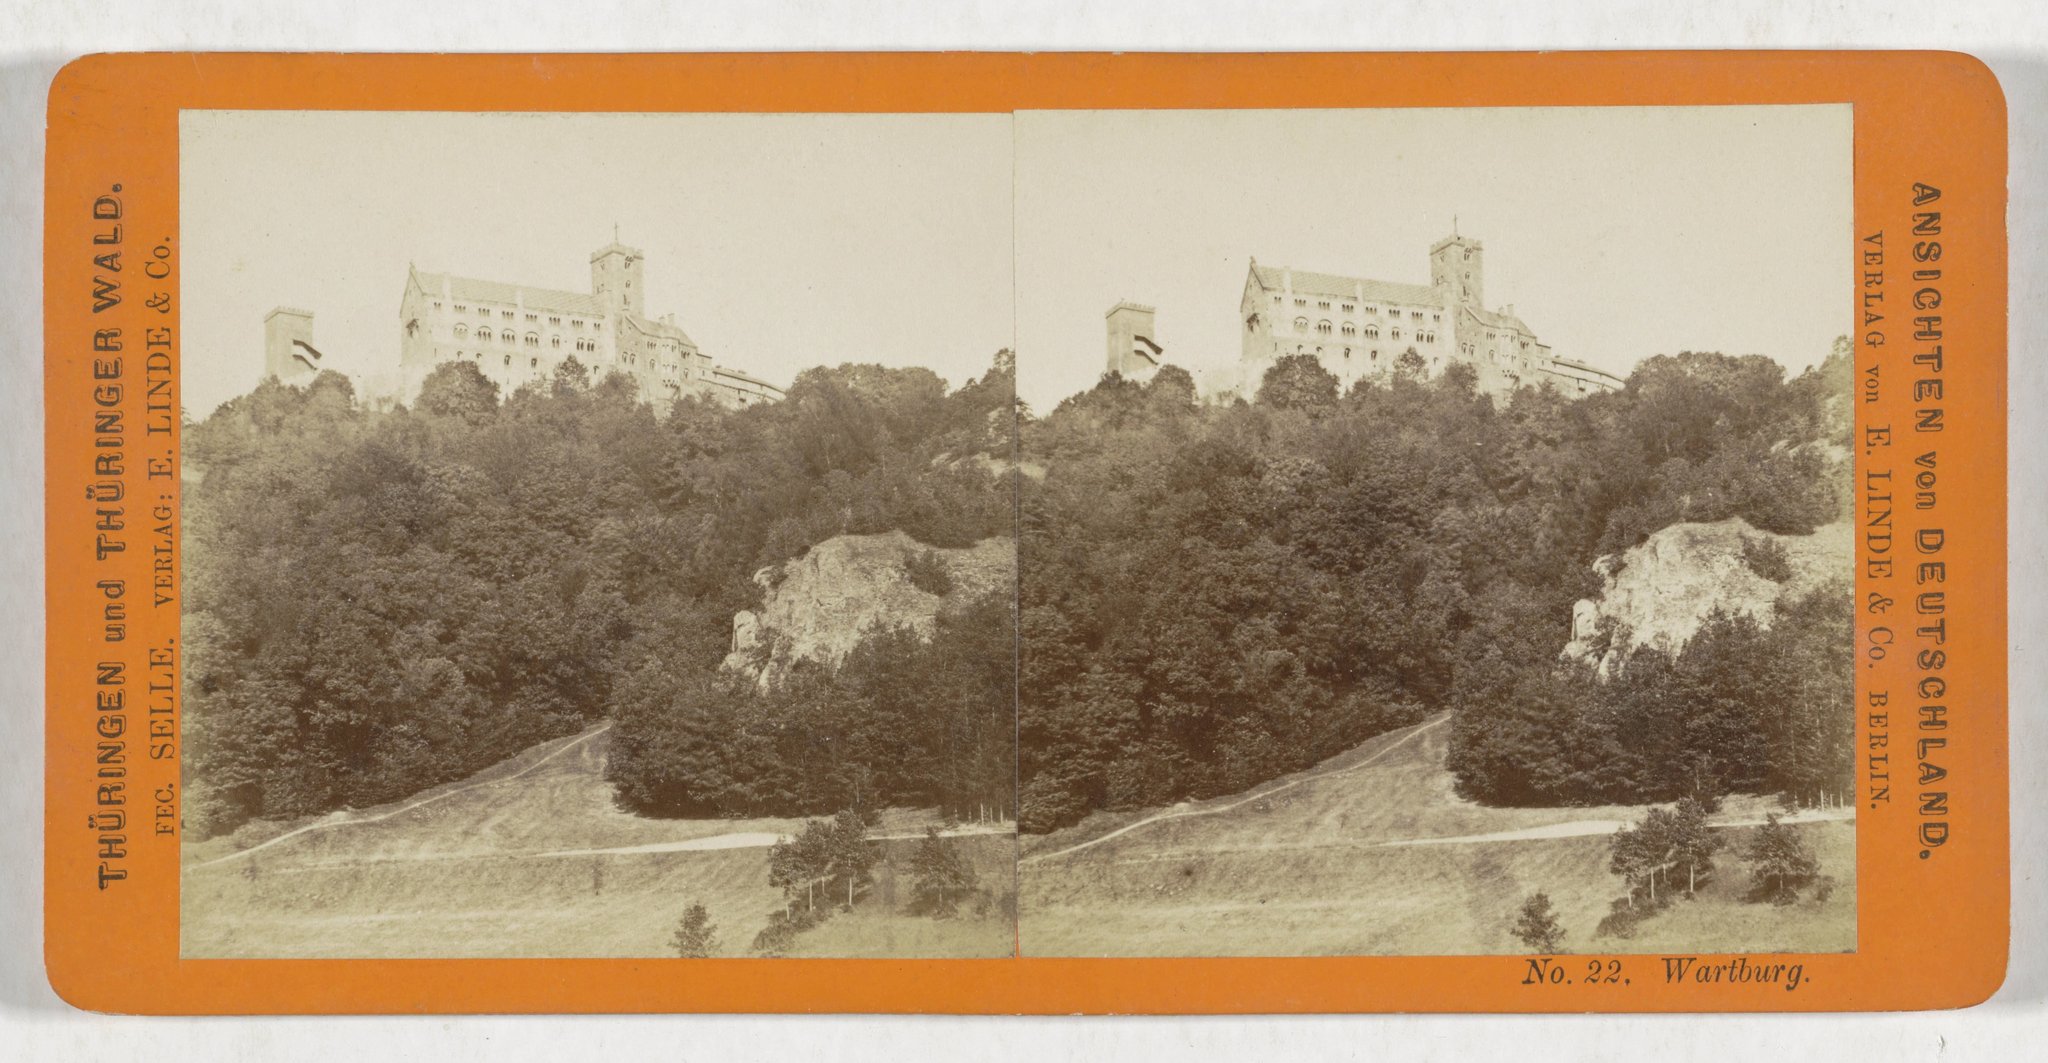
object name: stereograph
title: Wartburg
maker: hermann selle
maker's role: fotograaf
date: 1868-1890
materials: cardboard, paper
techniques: albumen print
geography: berlin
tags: castle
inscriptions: number: ‘No. 22.’